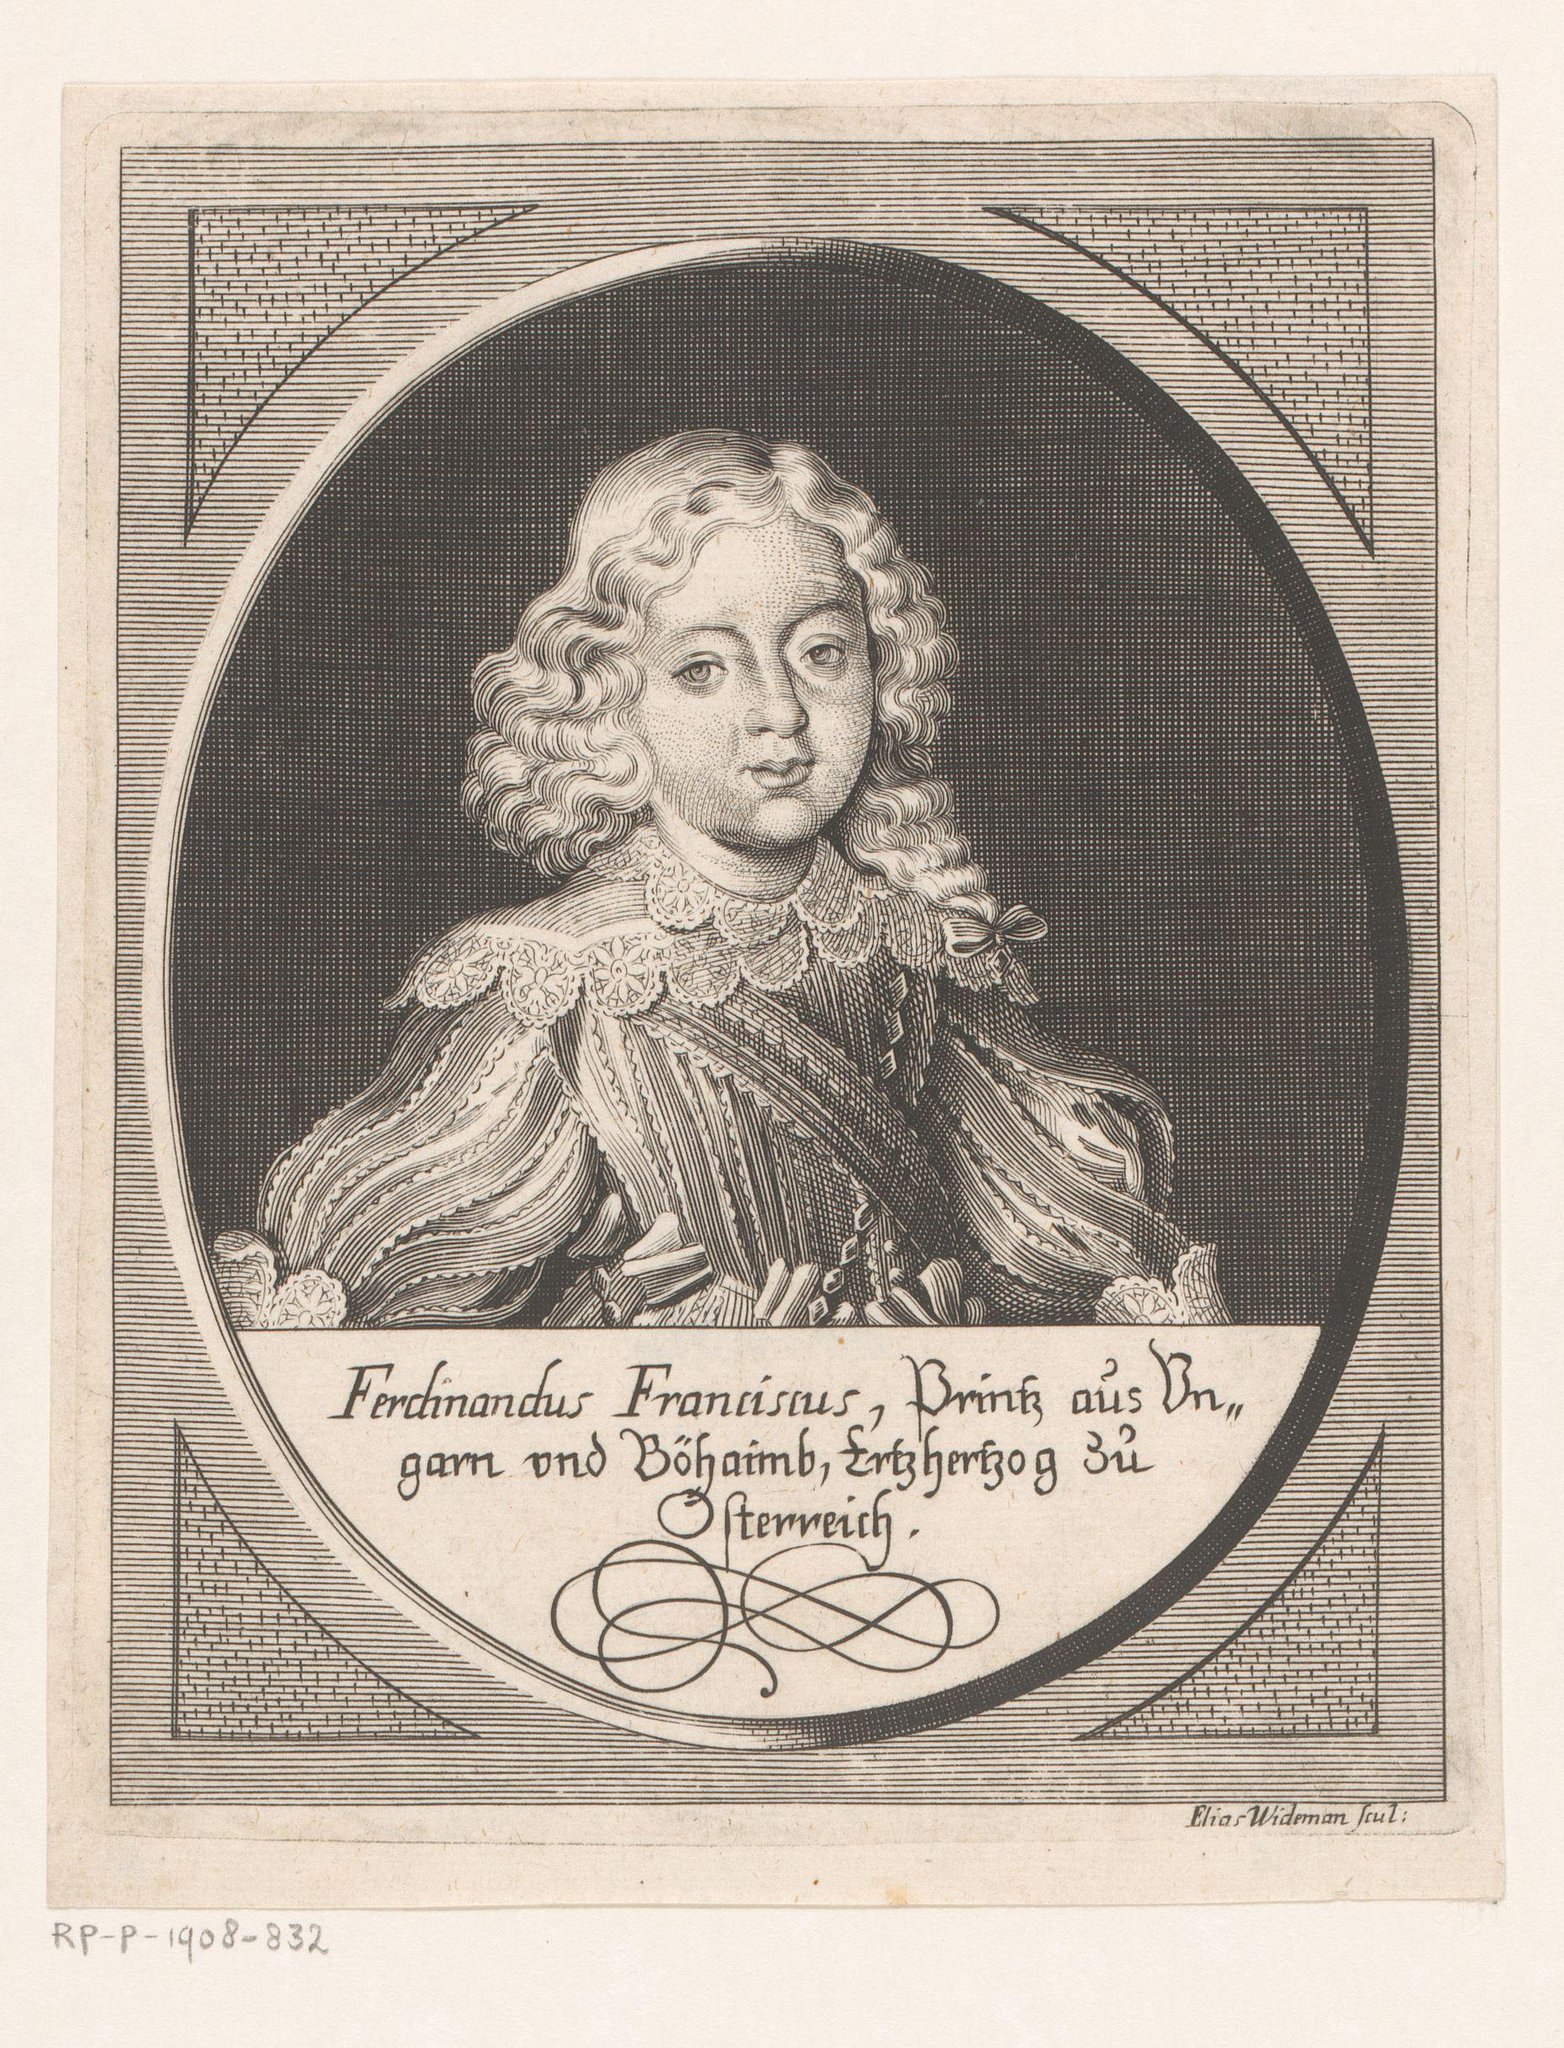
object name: print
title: Portret van Ferdinand IV, koning van Hongarije, Bohemen en het Heilige Roomse Rijk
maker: elias widemann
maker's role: print maker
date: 1640-1646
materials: paper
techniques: engraving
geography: austria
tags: vienna, historical persons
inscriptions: collector's mark: Lugt 2228